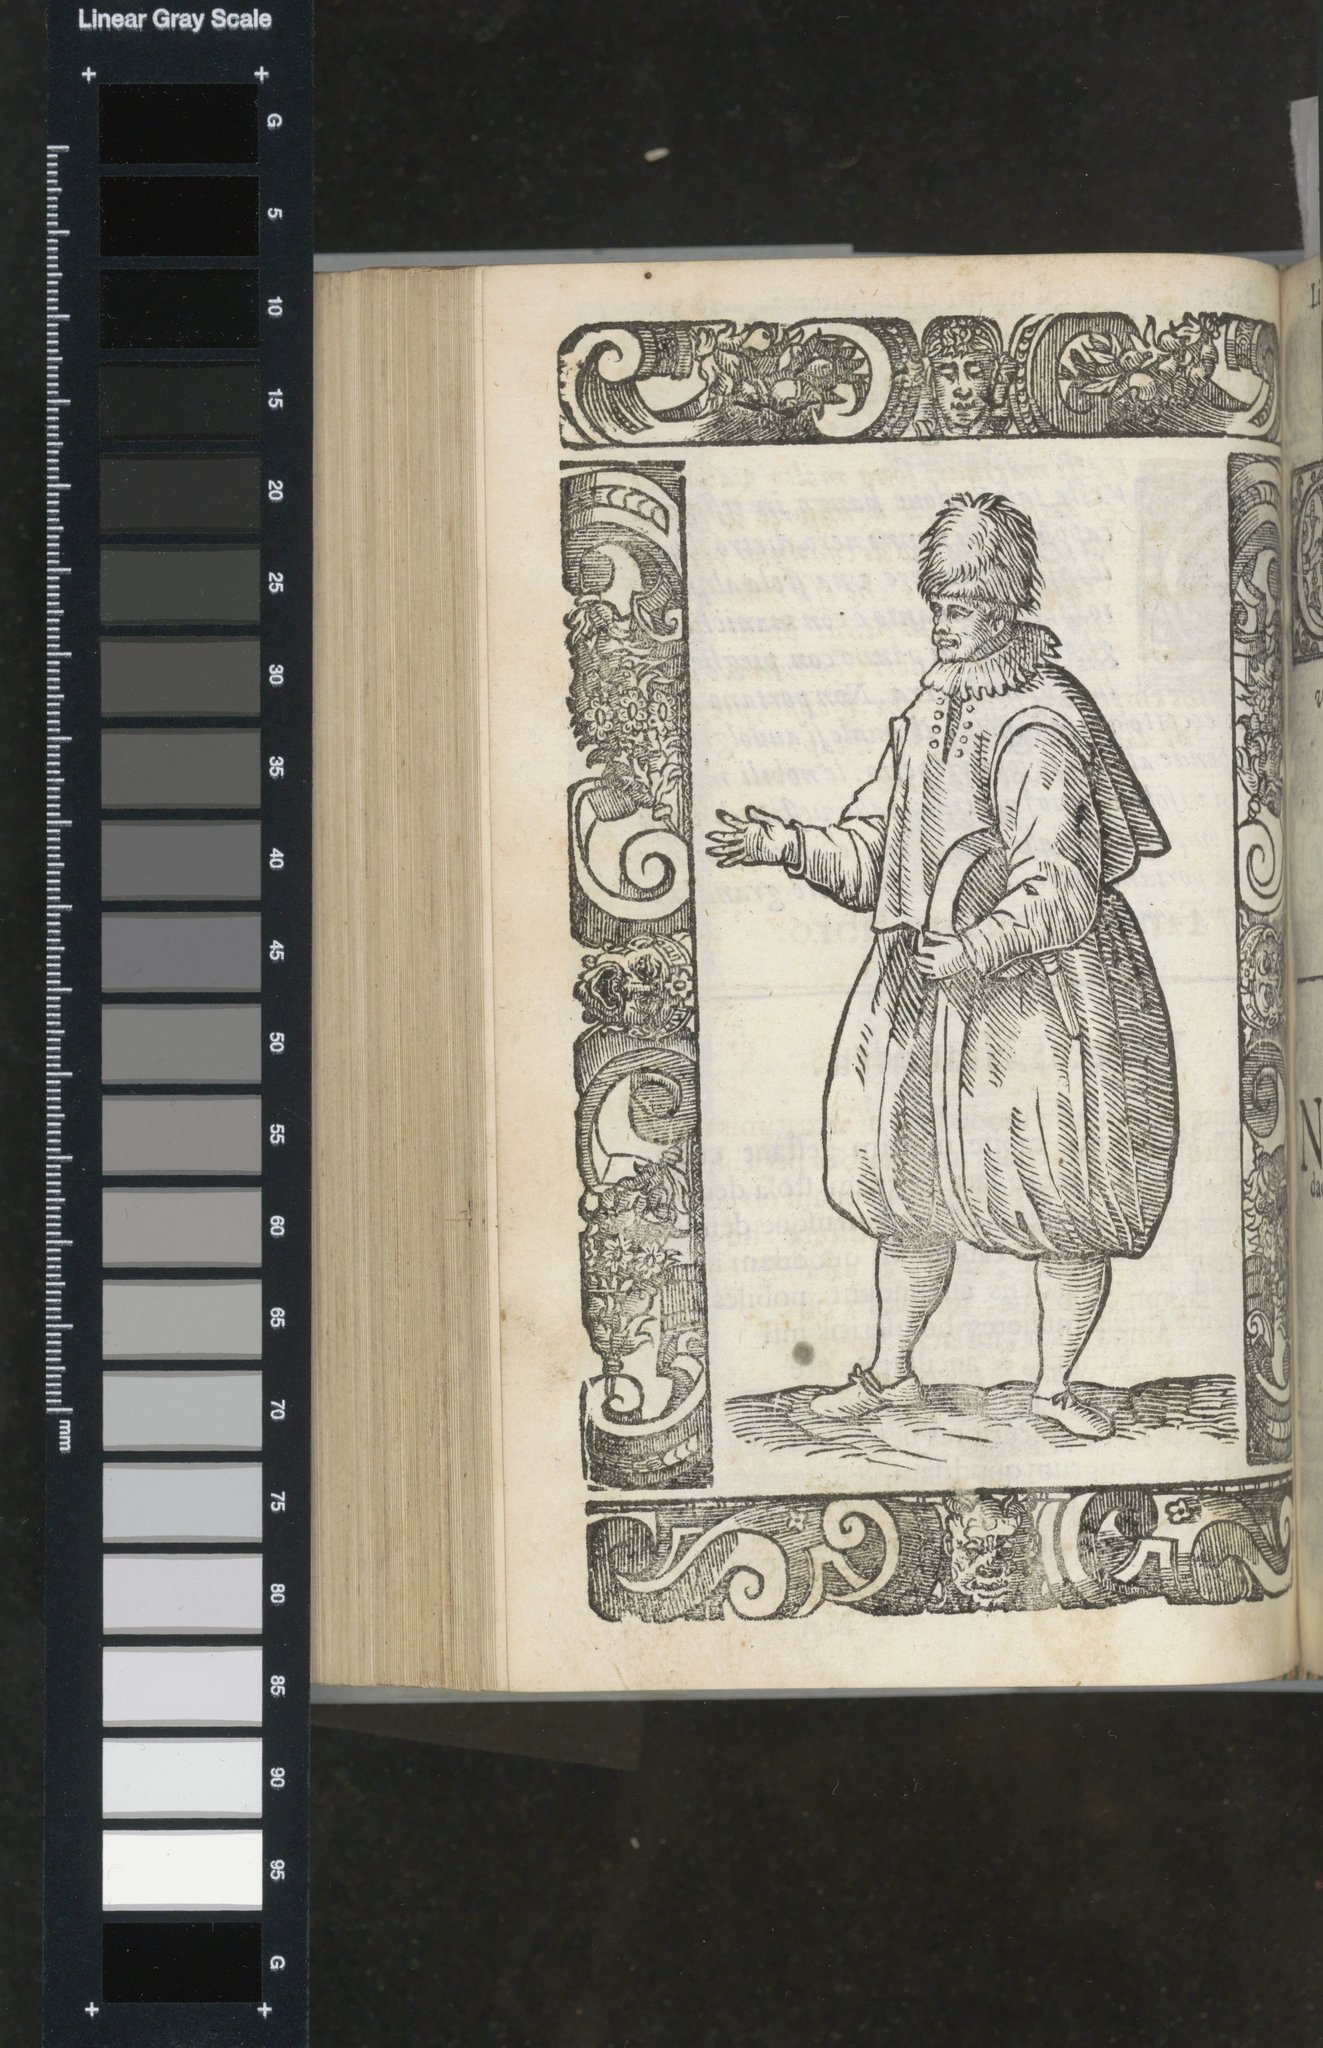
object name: costume print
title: Habiti antichi, et moderni di tutto il mondo...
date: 1598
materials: paper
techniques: woodcut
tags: fashion plates